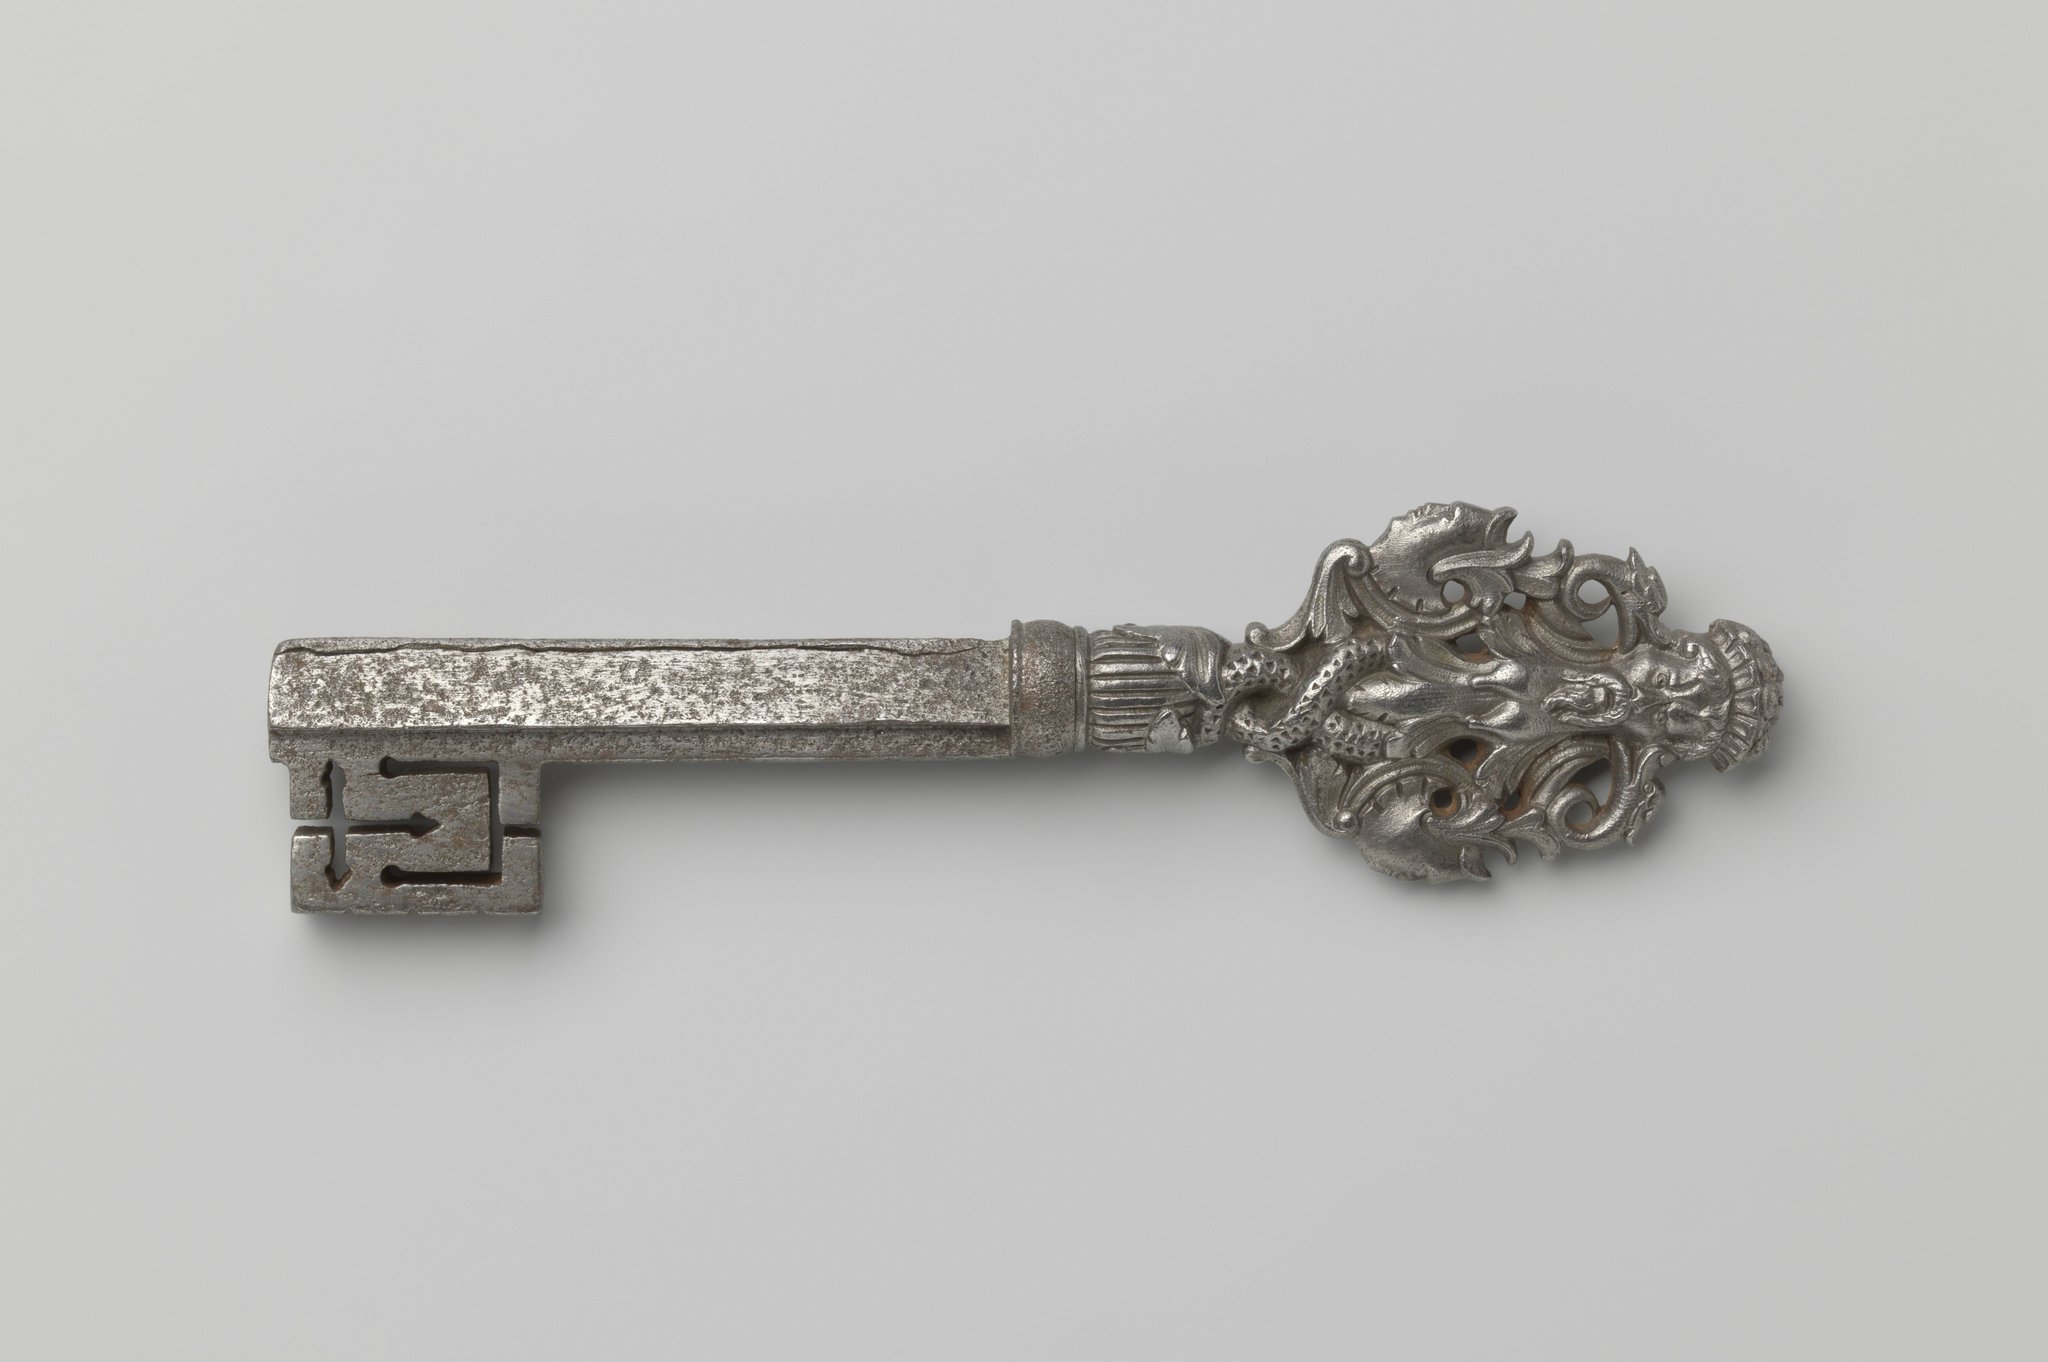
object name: key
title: Sleutel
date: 1600-1625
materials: iron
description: Geboorde sleutel met driezijdige pijp waarvan de greep bestaat uit een Neptunus en aan de andere zijde een zeemeermin; zij dragen een korfje gevuld met vruchten op het hoofd en zijn geplaatst tussen twee maskers, dolfijnen en bladranken.